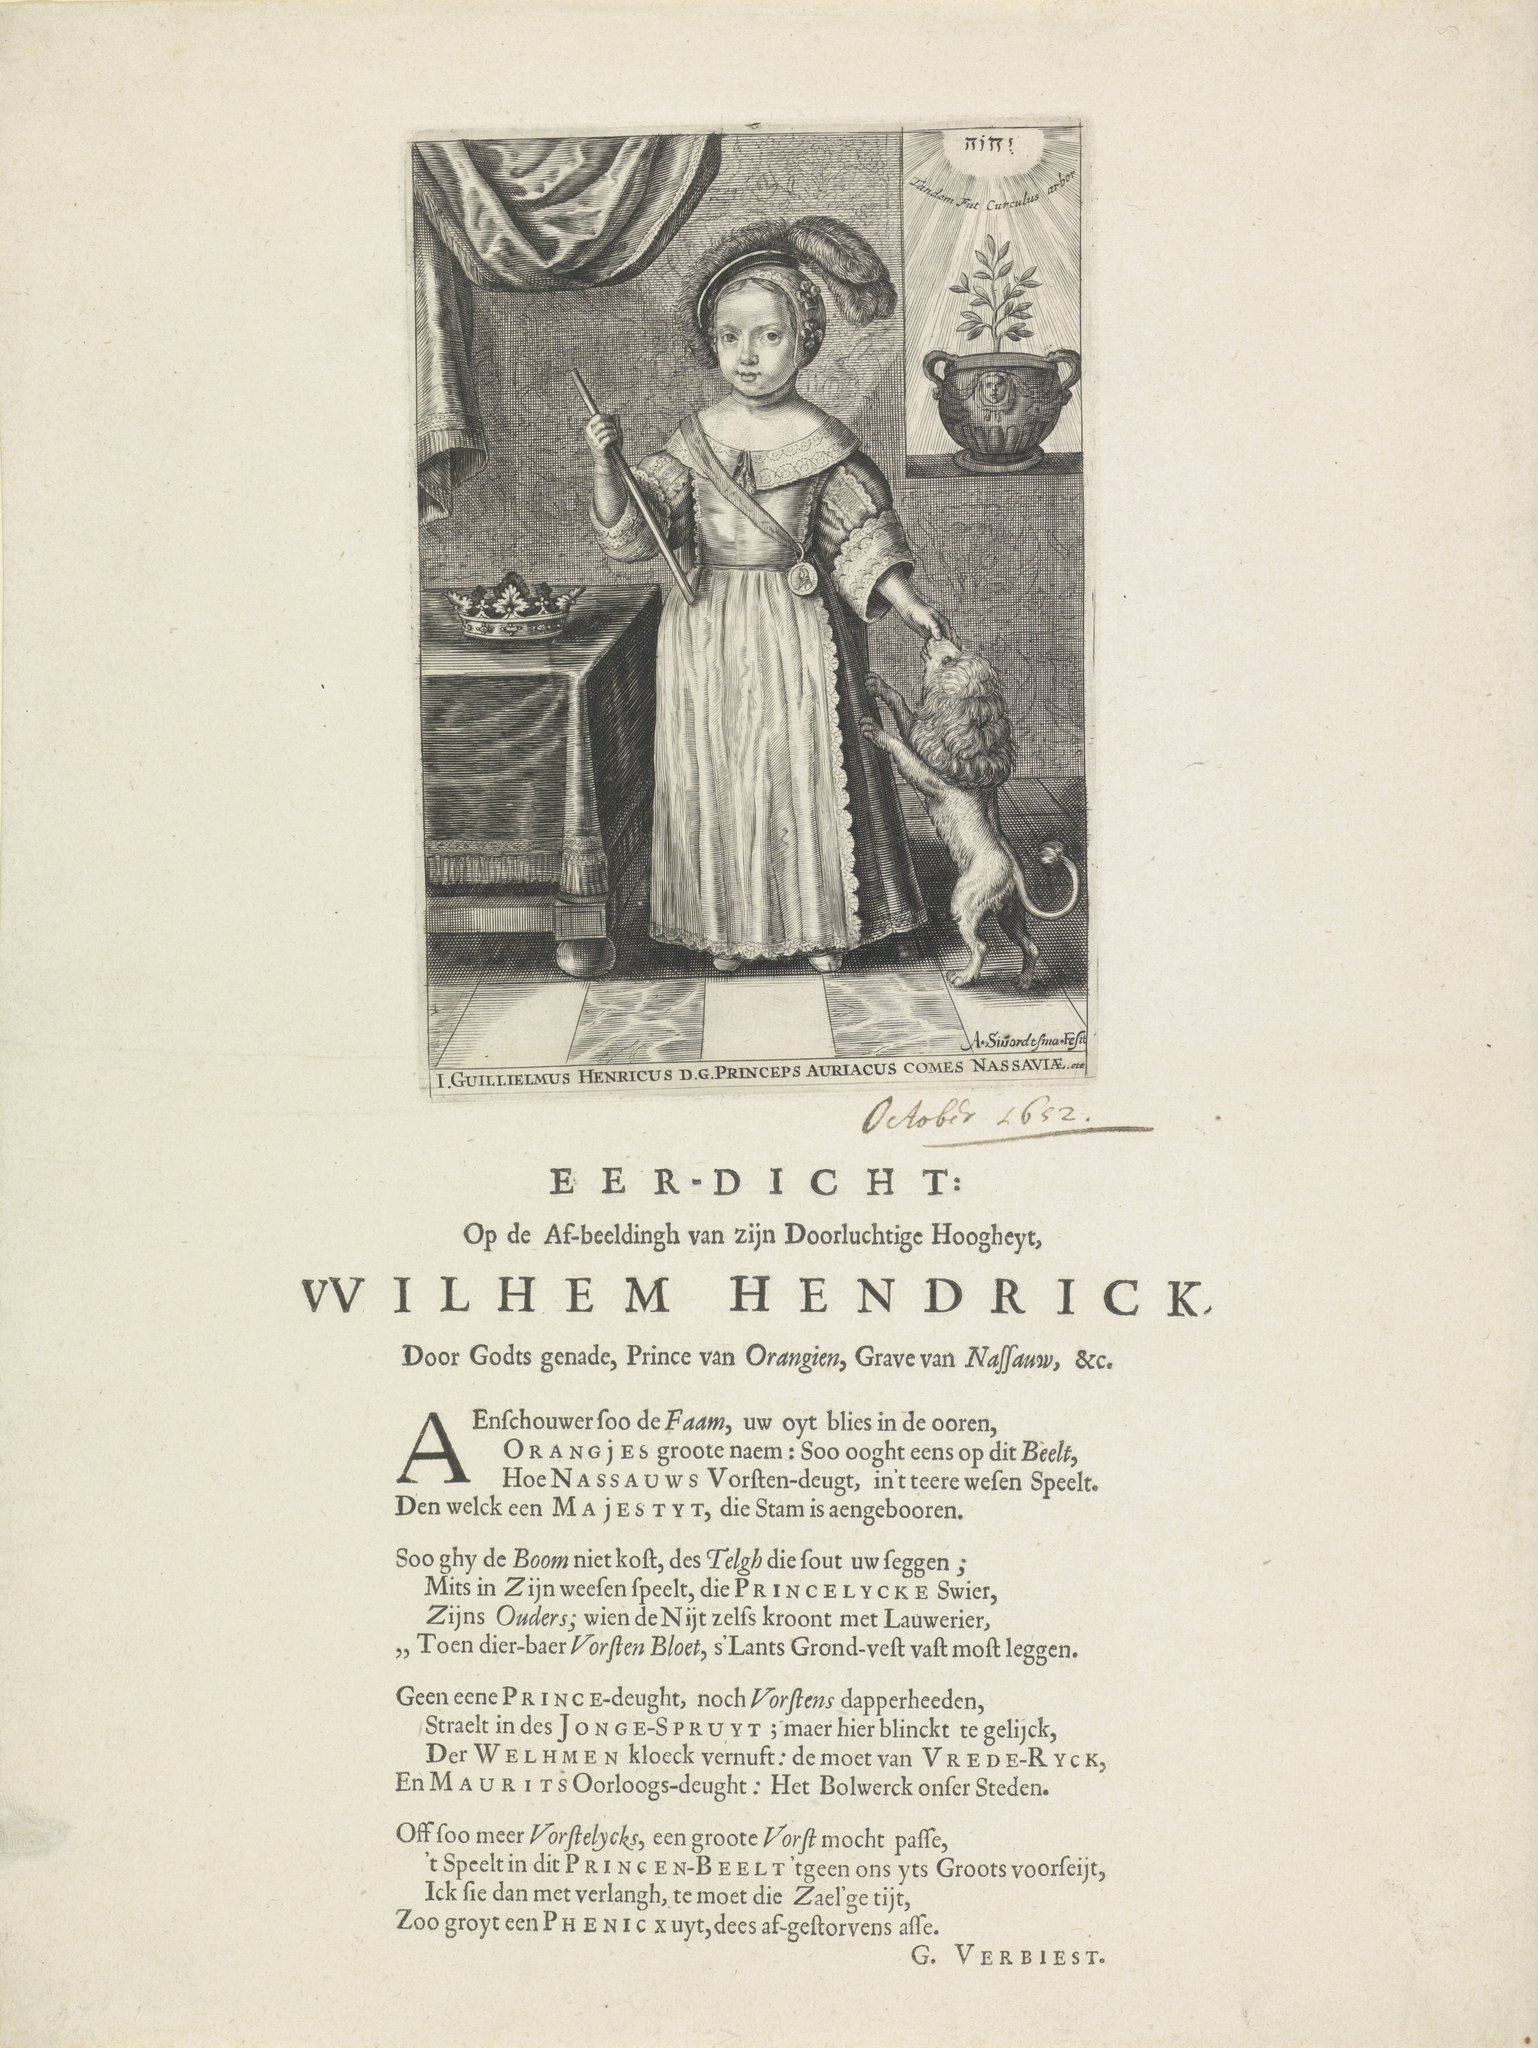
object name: print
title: Portret van Willem III, prins van Oranje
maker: anthonie heeres siverdtsma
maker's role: print maker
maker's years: 1625-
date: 1652-1662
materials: paper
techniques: engraving, letterpress printing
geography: amsterdam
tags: the hague, william iii (prince of orange and king of england, scotland, and ireland)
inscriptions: collector's mark: Lugt 240, inscription: ‘October 1652.’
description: Portret van Willem III als kind spelend met een hondje en staande bij een tafel waarop een kroon ligt. Rechts in een venster een pot met de oranjeboom waarop het goddelijk licht schijnt. In de marge een eenregelig Latijns onderschrift. Onder de prent een 'Eer-dicht: Op de Af-beeldingh van zijn Doorluchtige Hoogheyt, Wilhem Hendrick, door Godts genade, Prince van Orangien, Grave van Nassauw, &c.' door G. Verbiest. Onder het portret is met de hand geschreven: October 1652.